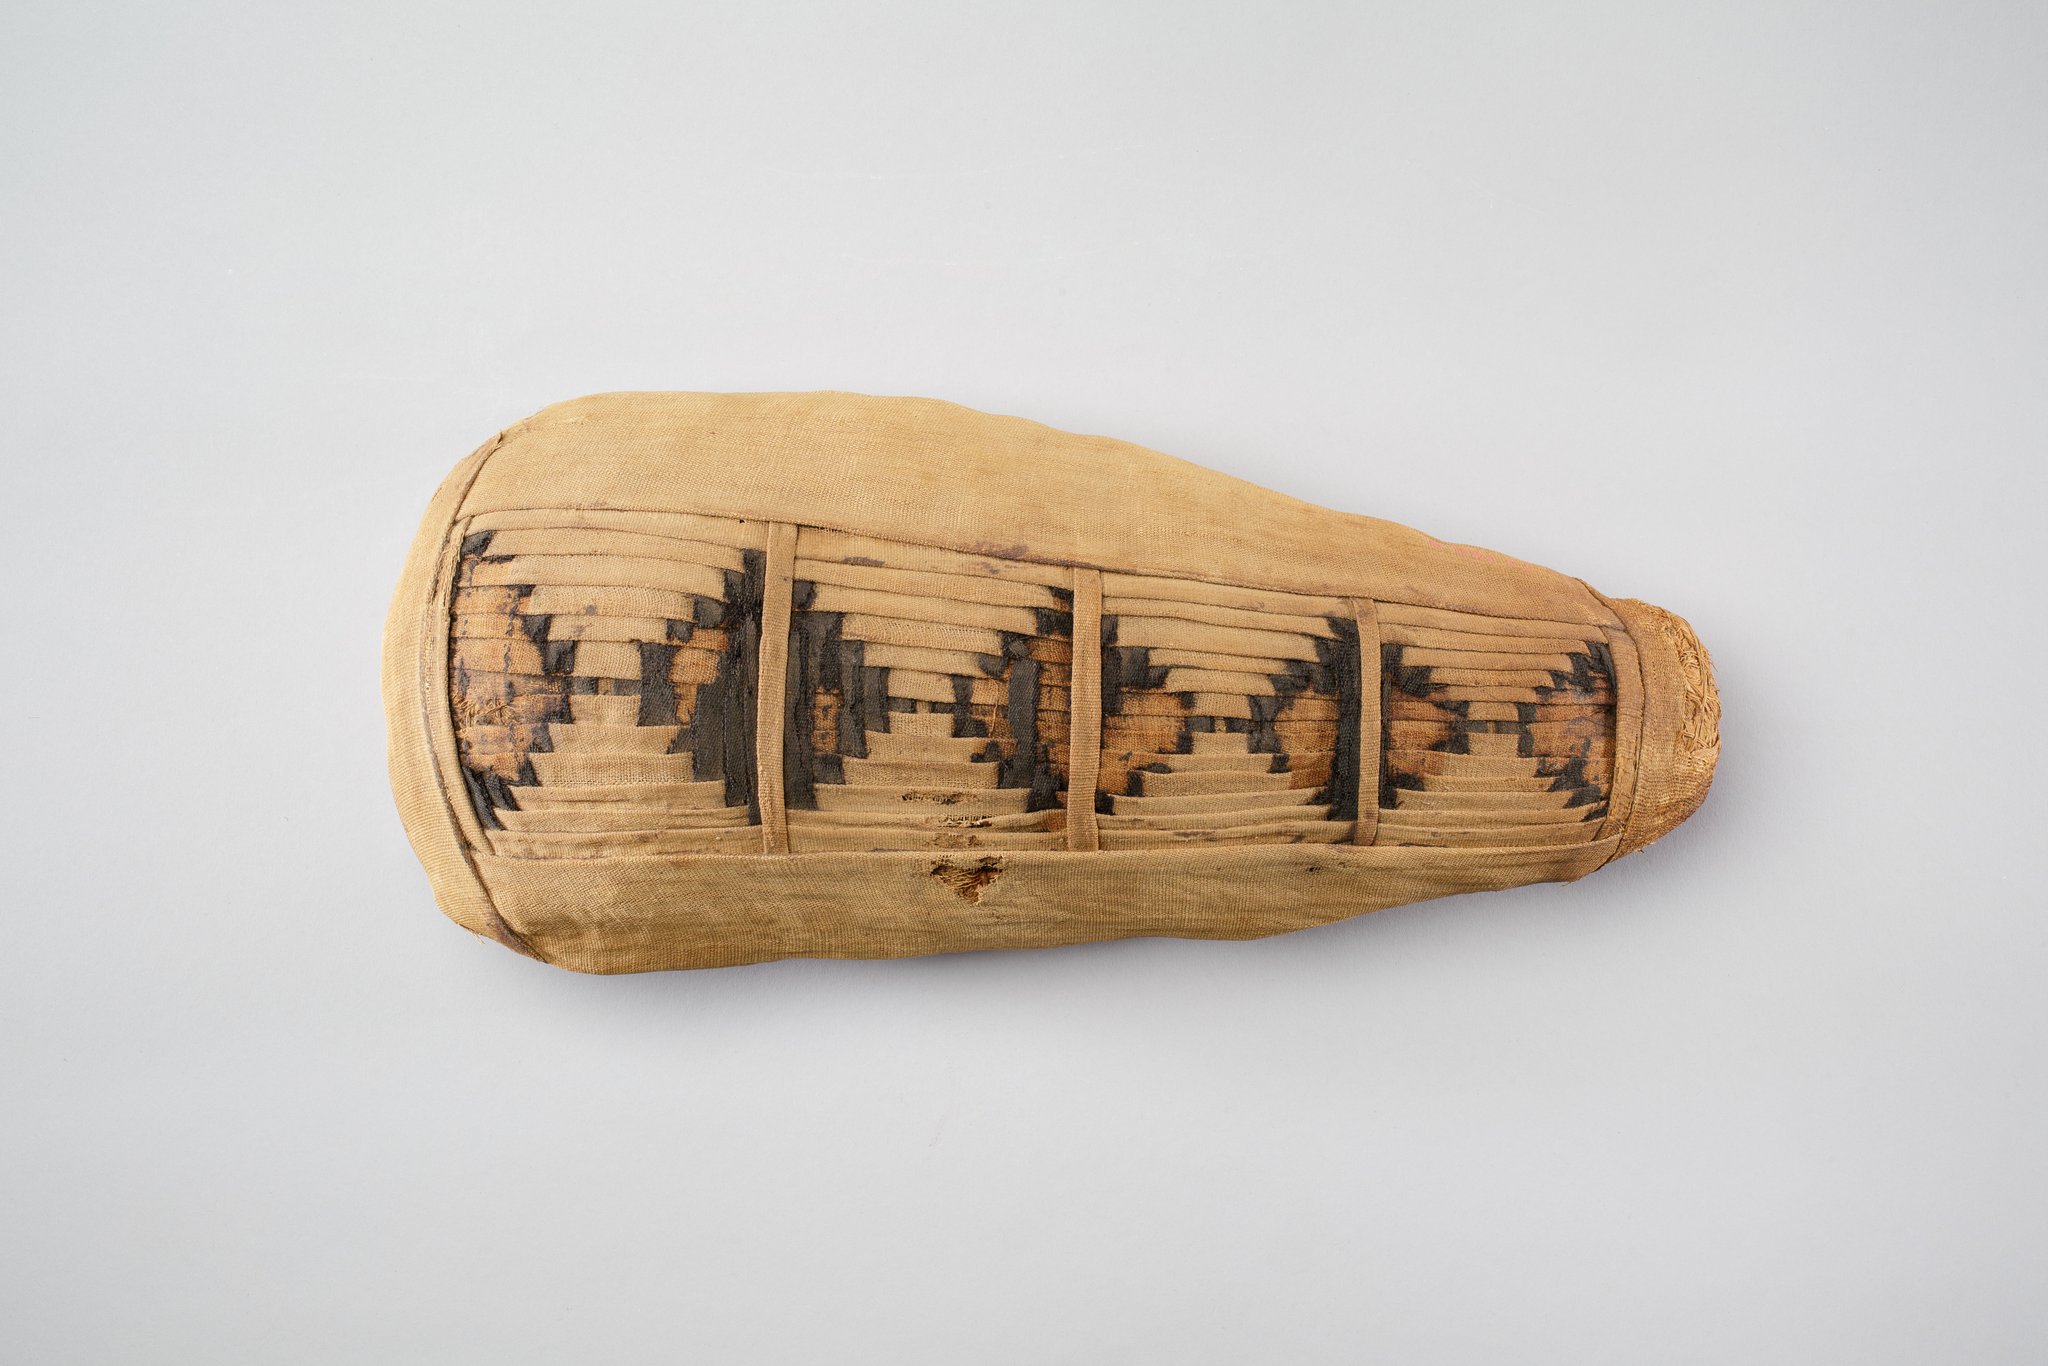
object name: mummy, ibis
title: Sacred animal mummy containing small ibises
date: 400 BCE-100 CE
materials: linen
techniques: dyeing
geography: egypt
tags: birds,mummies